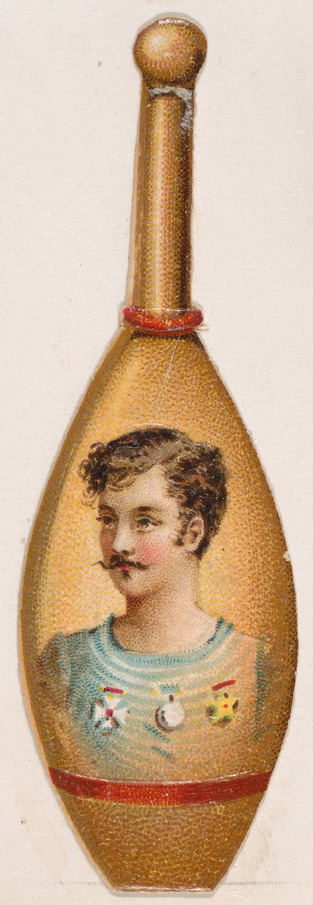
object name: print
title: Indian club, from the Novelties series (N228, Type 4) issued by Kinney Bros.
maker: kinney brothers tobacco company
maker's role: publisher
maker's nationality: american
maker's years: 1869-2011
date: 1889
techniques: color lithograph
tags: men